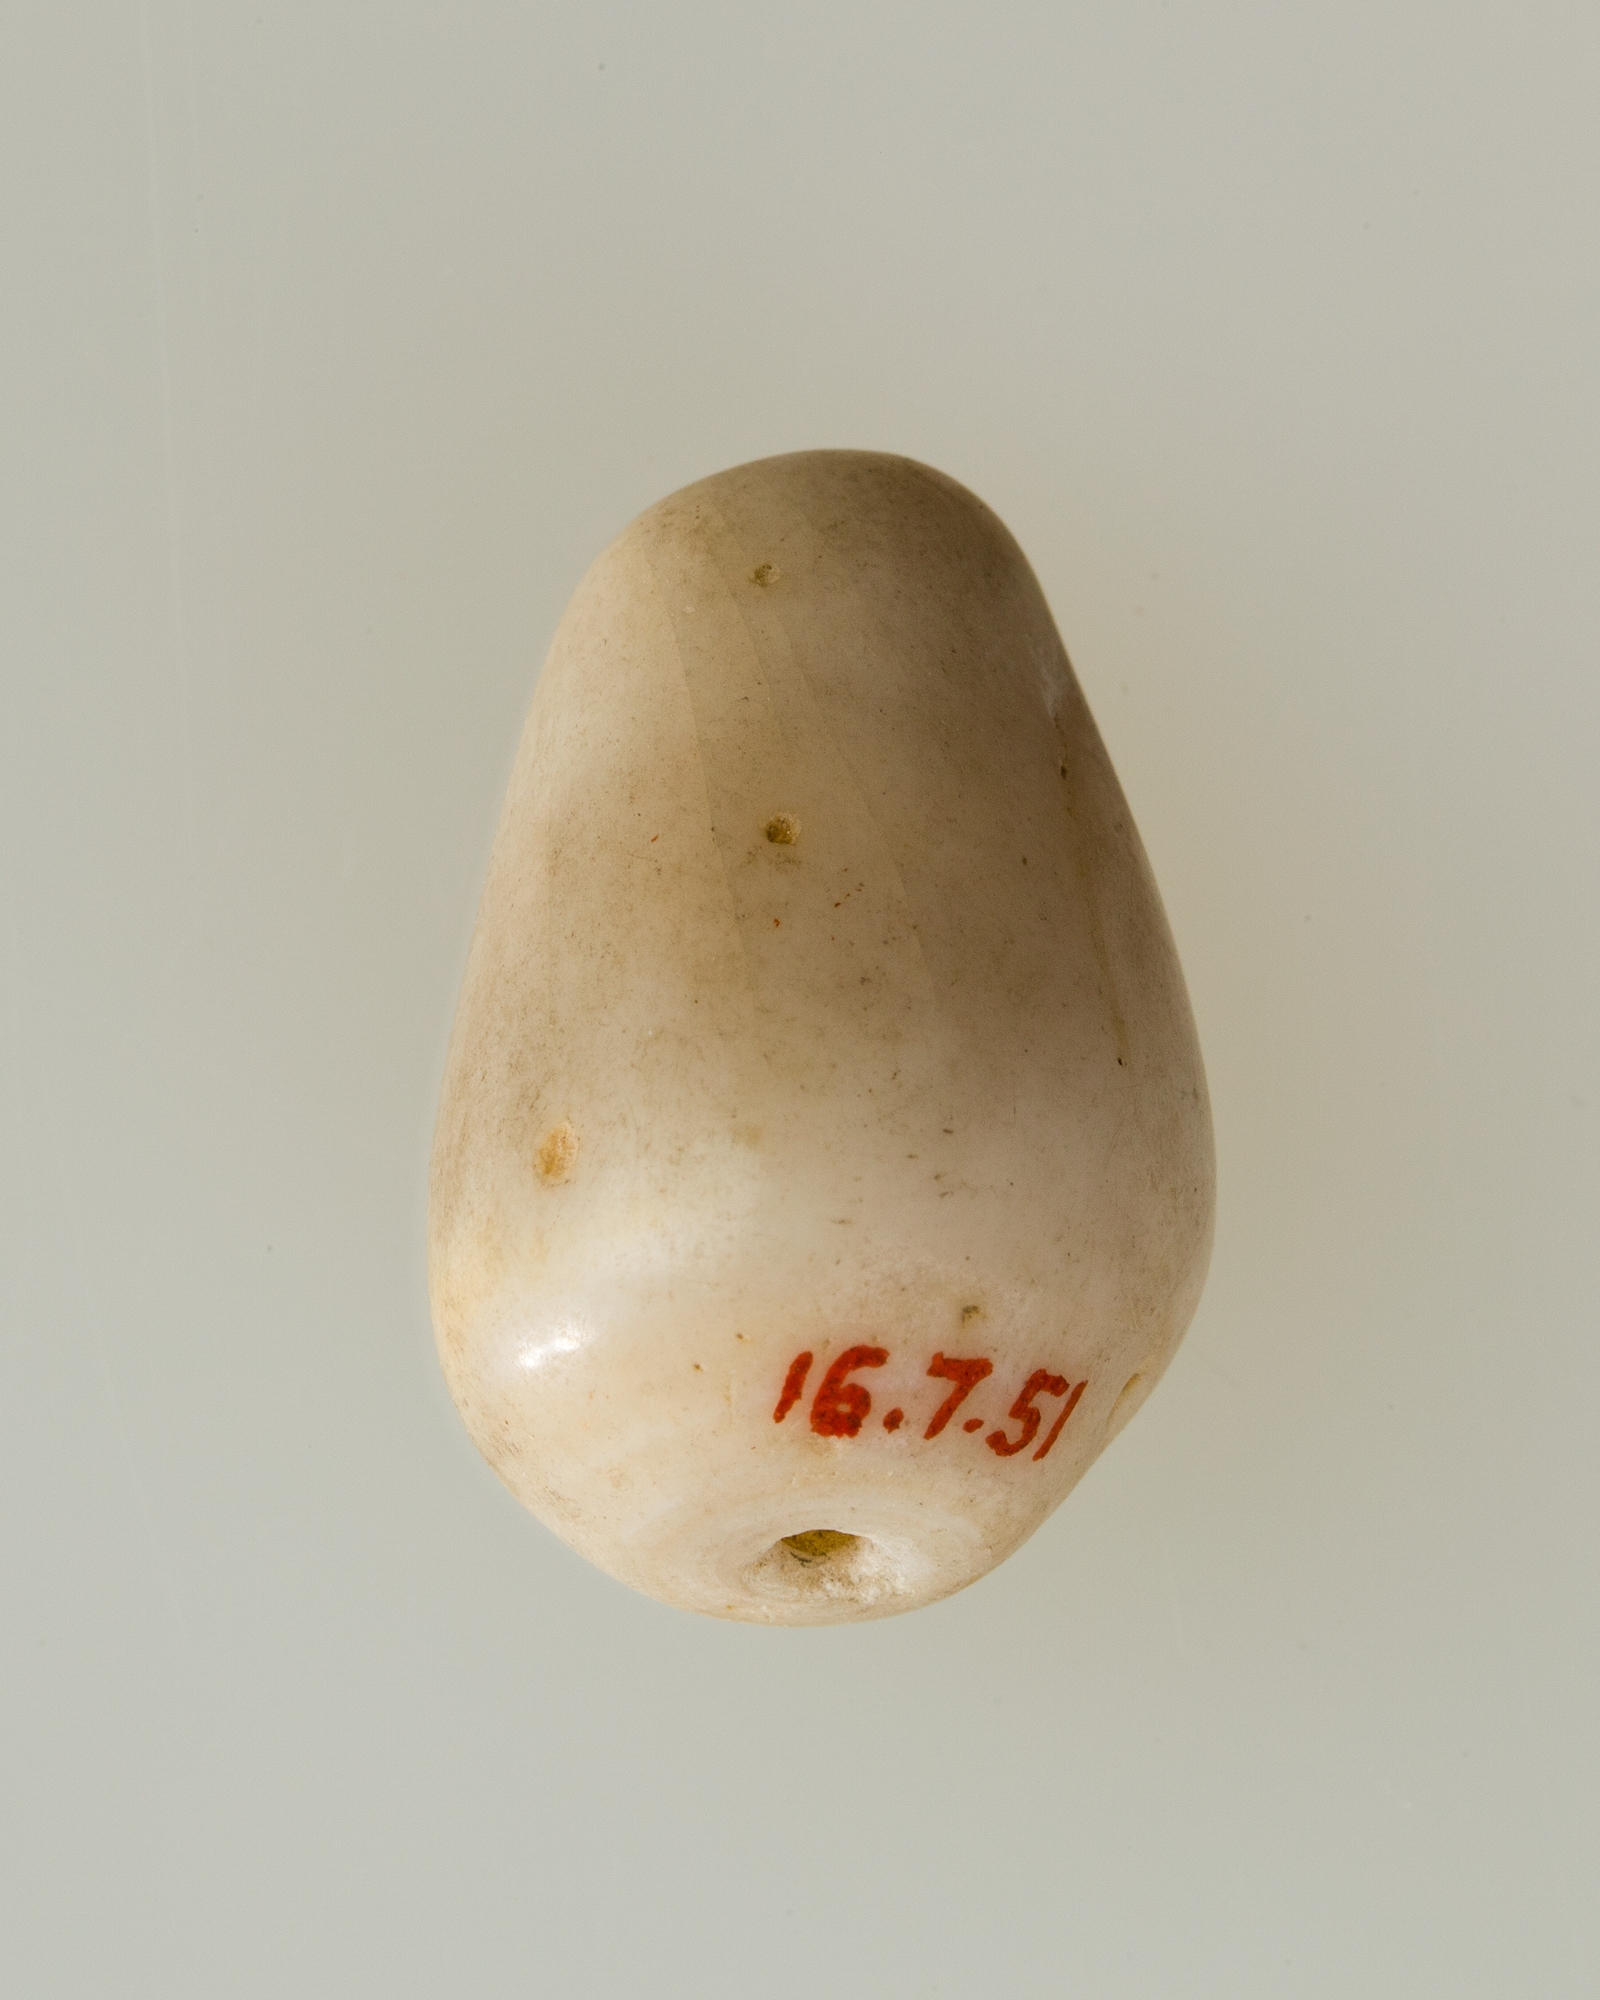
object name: pendant, shell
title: Shell pendant or bead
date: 3850-2960 BCE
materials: shell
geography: egypt